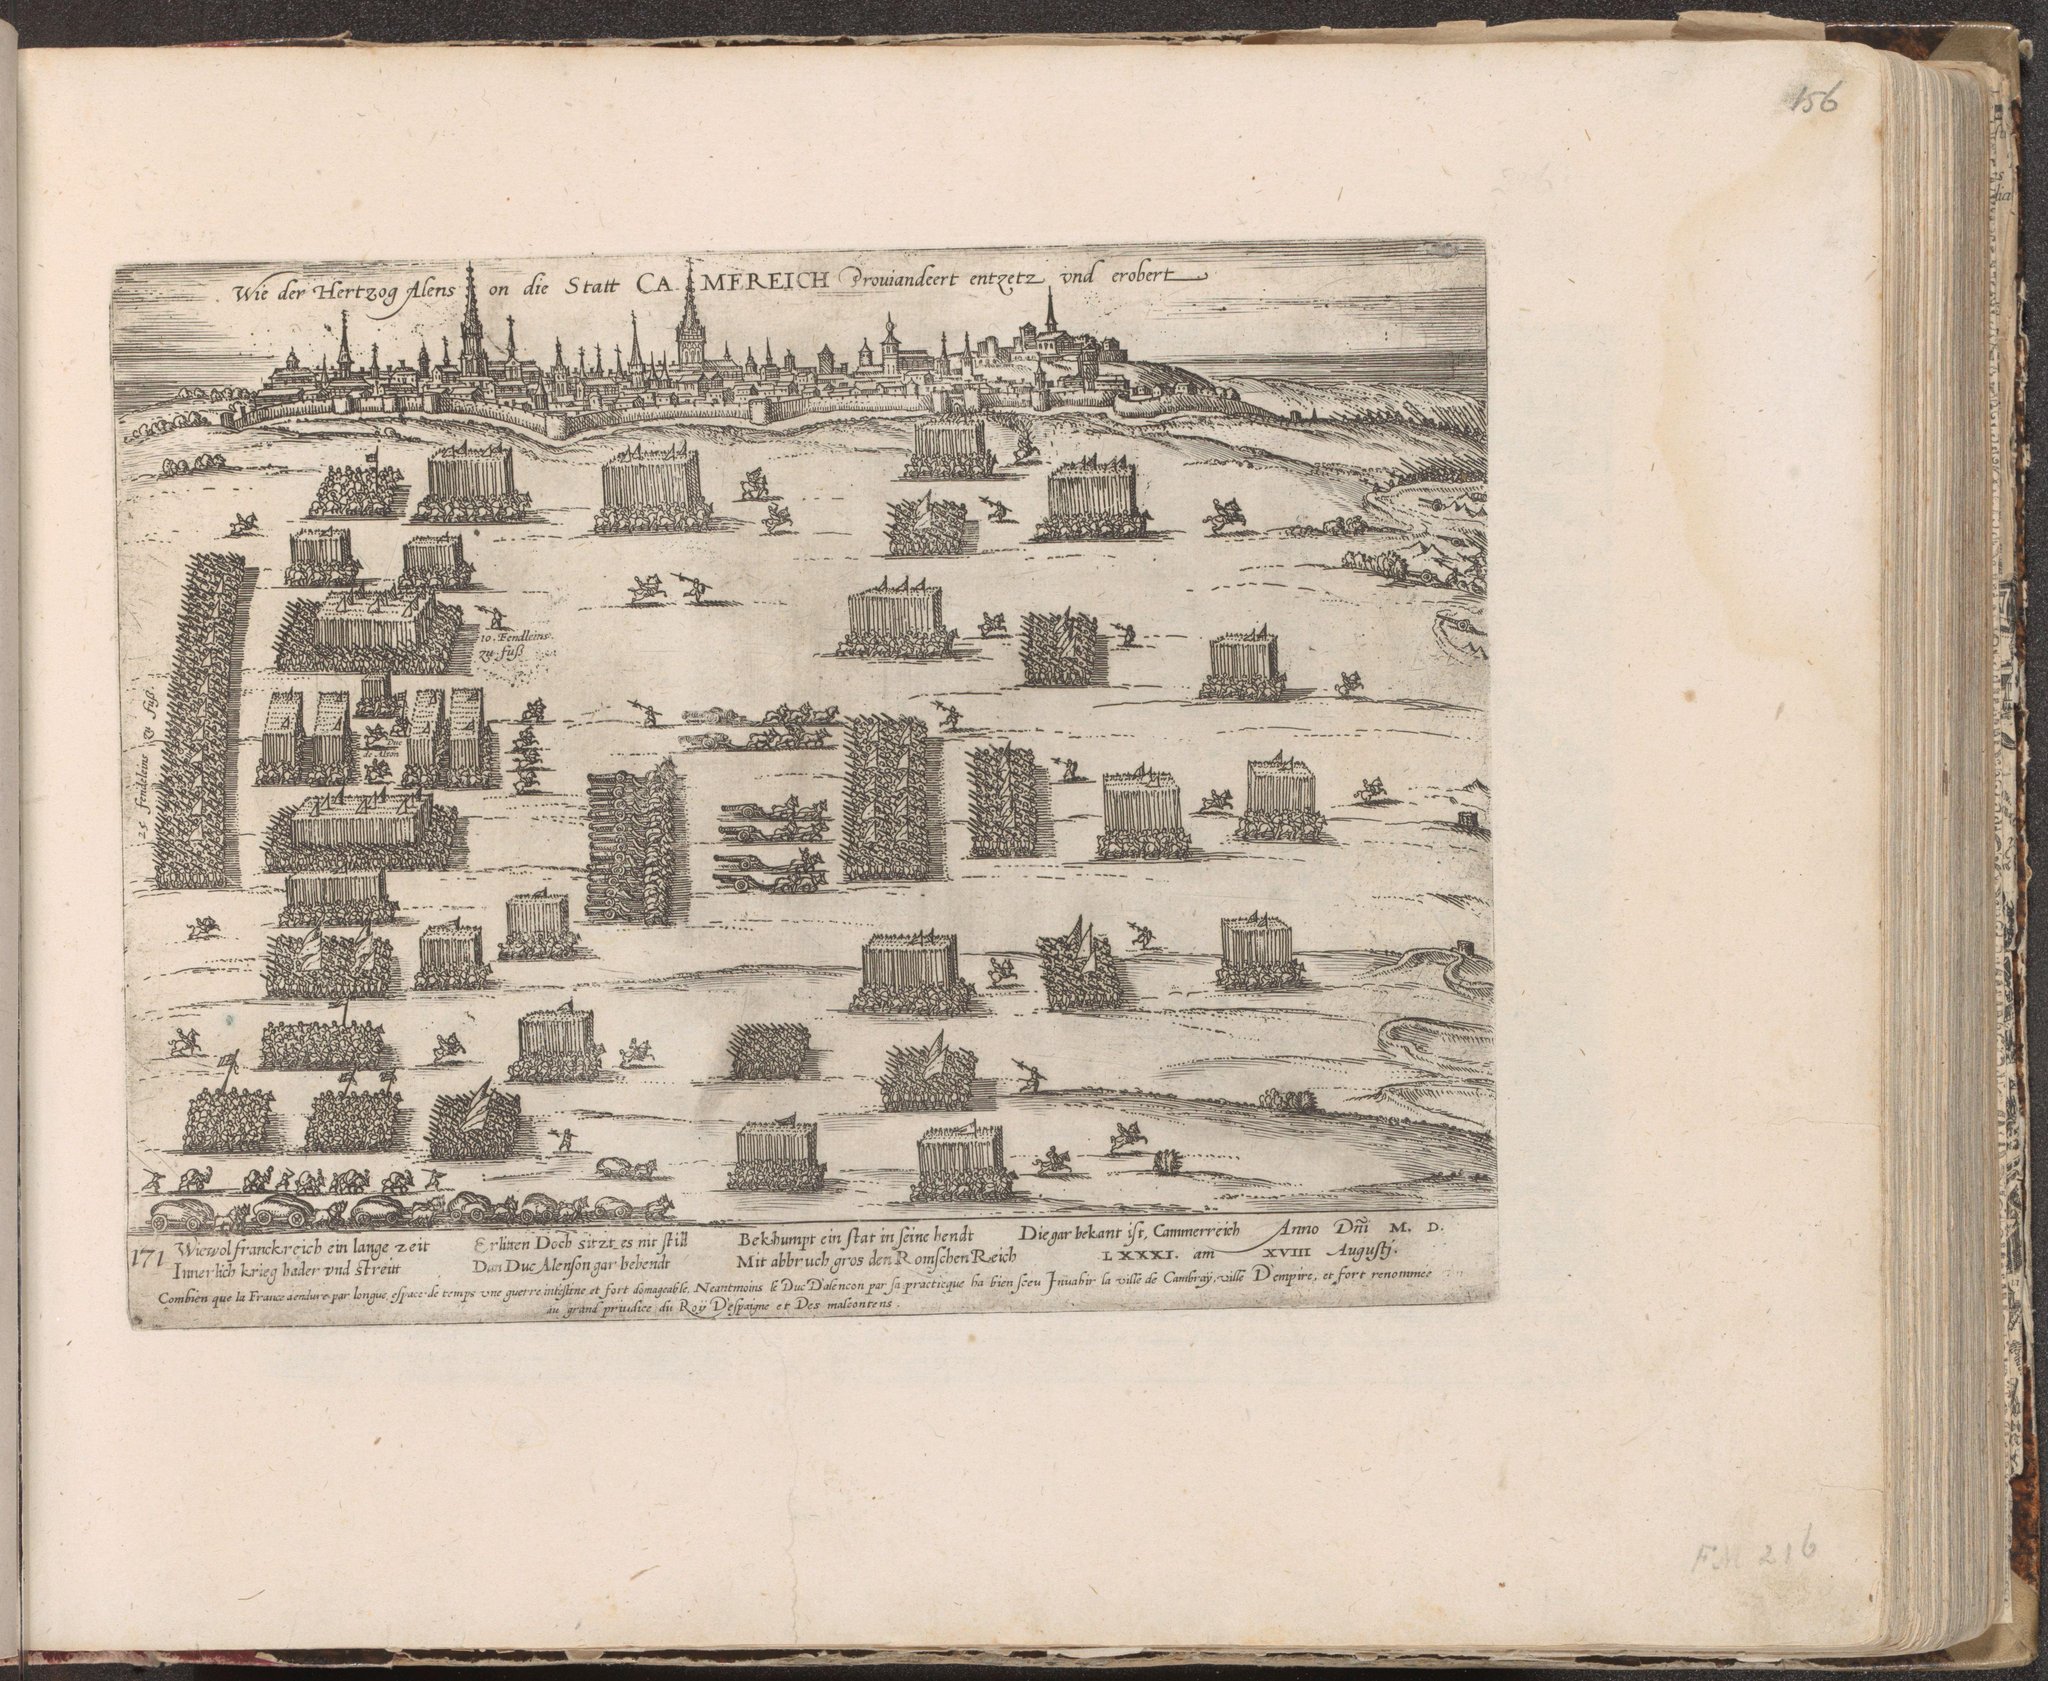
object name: print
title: Kamerijk ontzet door de hertog van Anjou, 1581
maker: frans hogenberg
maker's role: print maker, publisher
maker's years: 1538-1590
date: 1581-1585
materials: paper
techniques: etching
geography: cologne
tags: paris, françois-hercule de valois (hertog van anjou), capture of city (after the siege)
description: Kamerijk, belegerd door de troepen van Parma, wordt ontzet en van proviand voorzien door de hertog van Anjou, 18 augustus 1581. Het leger van Anjou met wagens met proviand opgesteld voor de stad. Met onderschrift van 8 regels in het Duits en 2 regels in het Frans. Linksonder genummerd: 171. De prent maakt deel uit van een album.